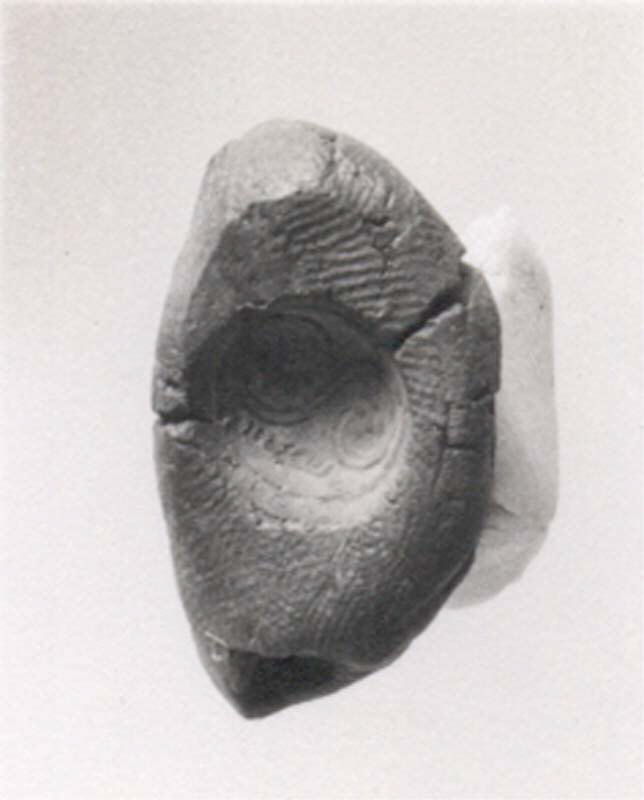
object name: sealing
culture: sasanian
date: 601-700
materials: clay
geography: iran